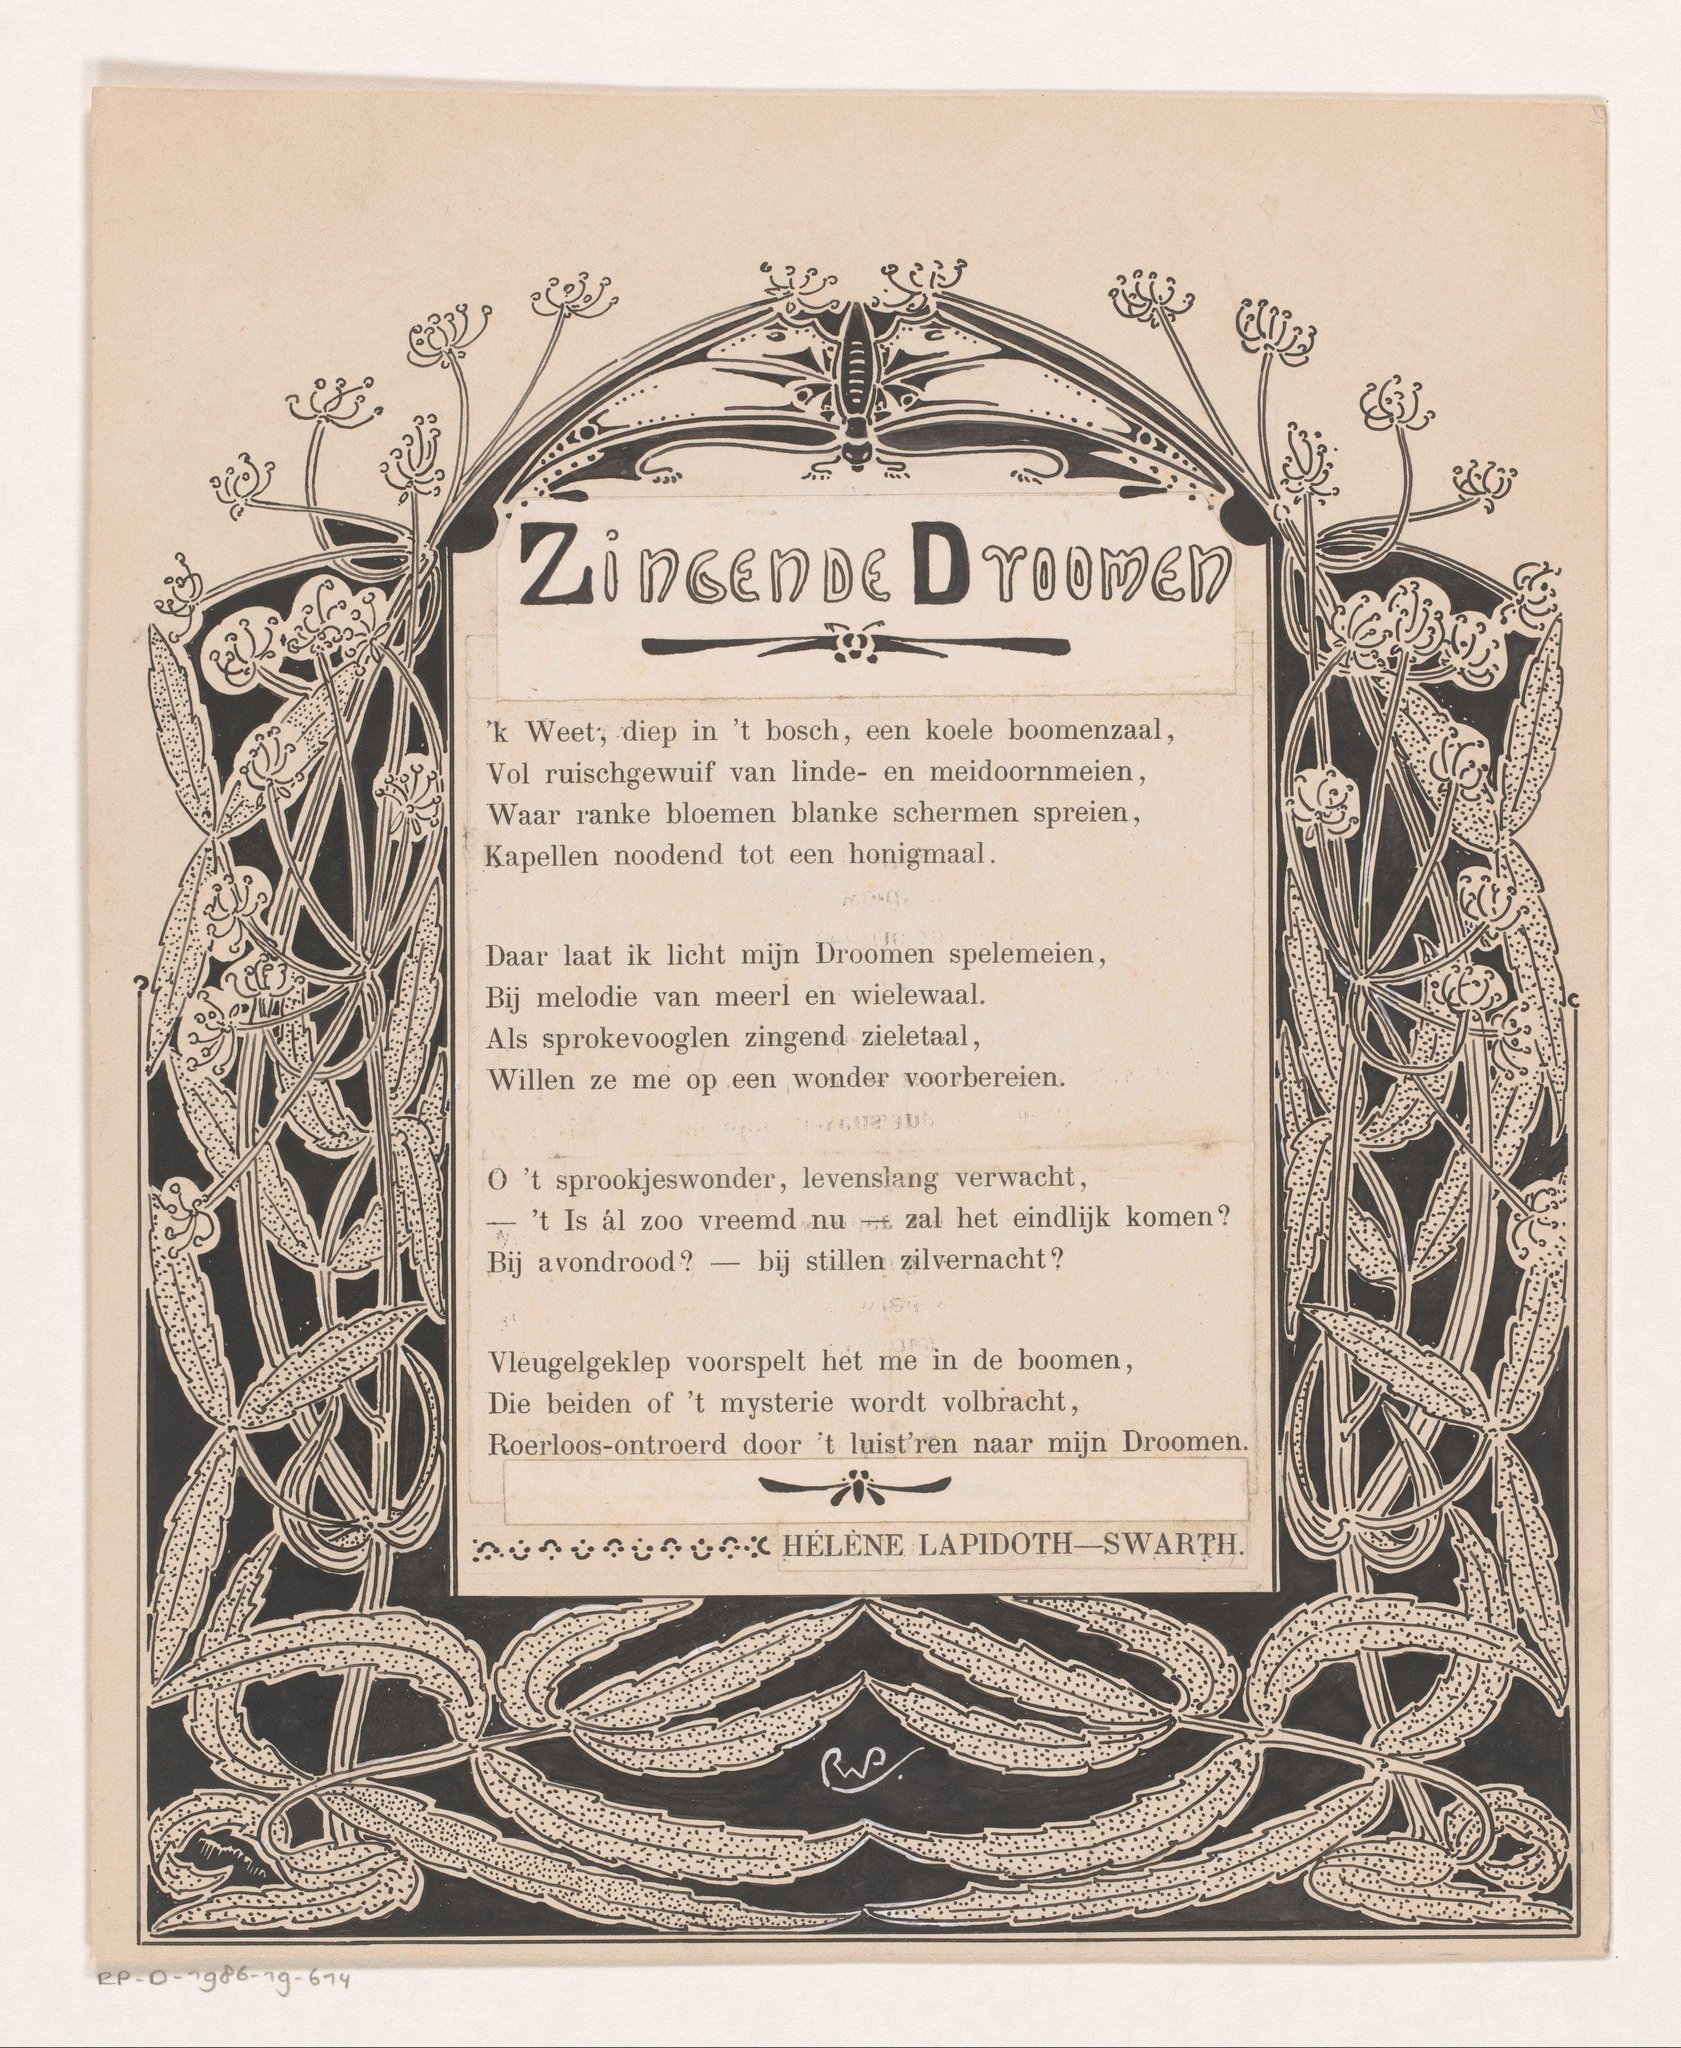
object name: drawing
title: Omlijsting voor het gedicht 'Zingende Droomen' van Hélène Lapidoth-Swarth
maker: reinier willem petrus de vries (1874-1953)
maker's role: draughtsman, print maker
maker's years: 1874-1953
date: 1896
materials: paint, ink, paper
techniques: brush, letterpress printing, pen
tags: hélène swarth, ornament derived from plant forms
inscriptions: collector's mark: ‘R:MVS.’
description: Het gedicht met omlijsting werd gepubliceerd in: Woord en Beeld. Geïllustreerd maandschrift, september 1896.